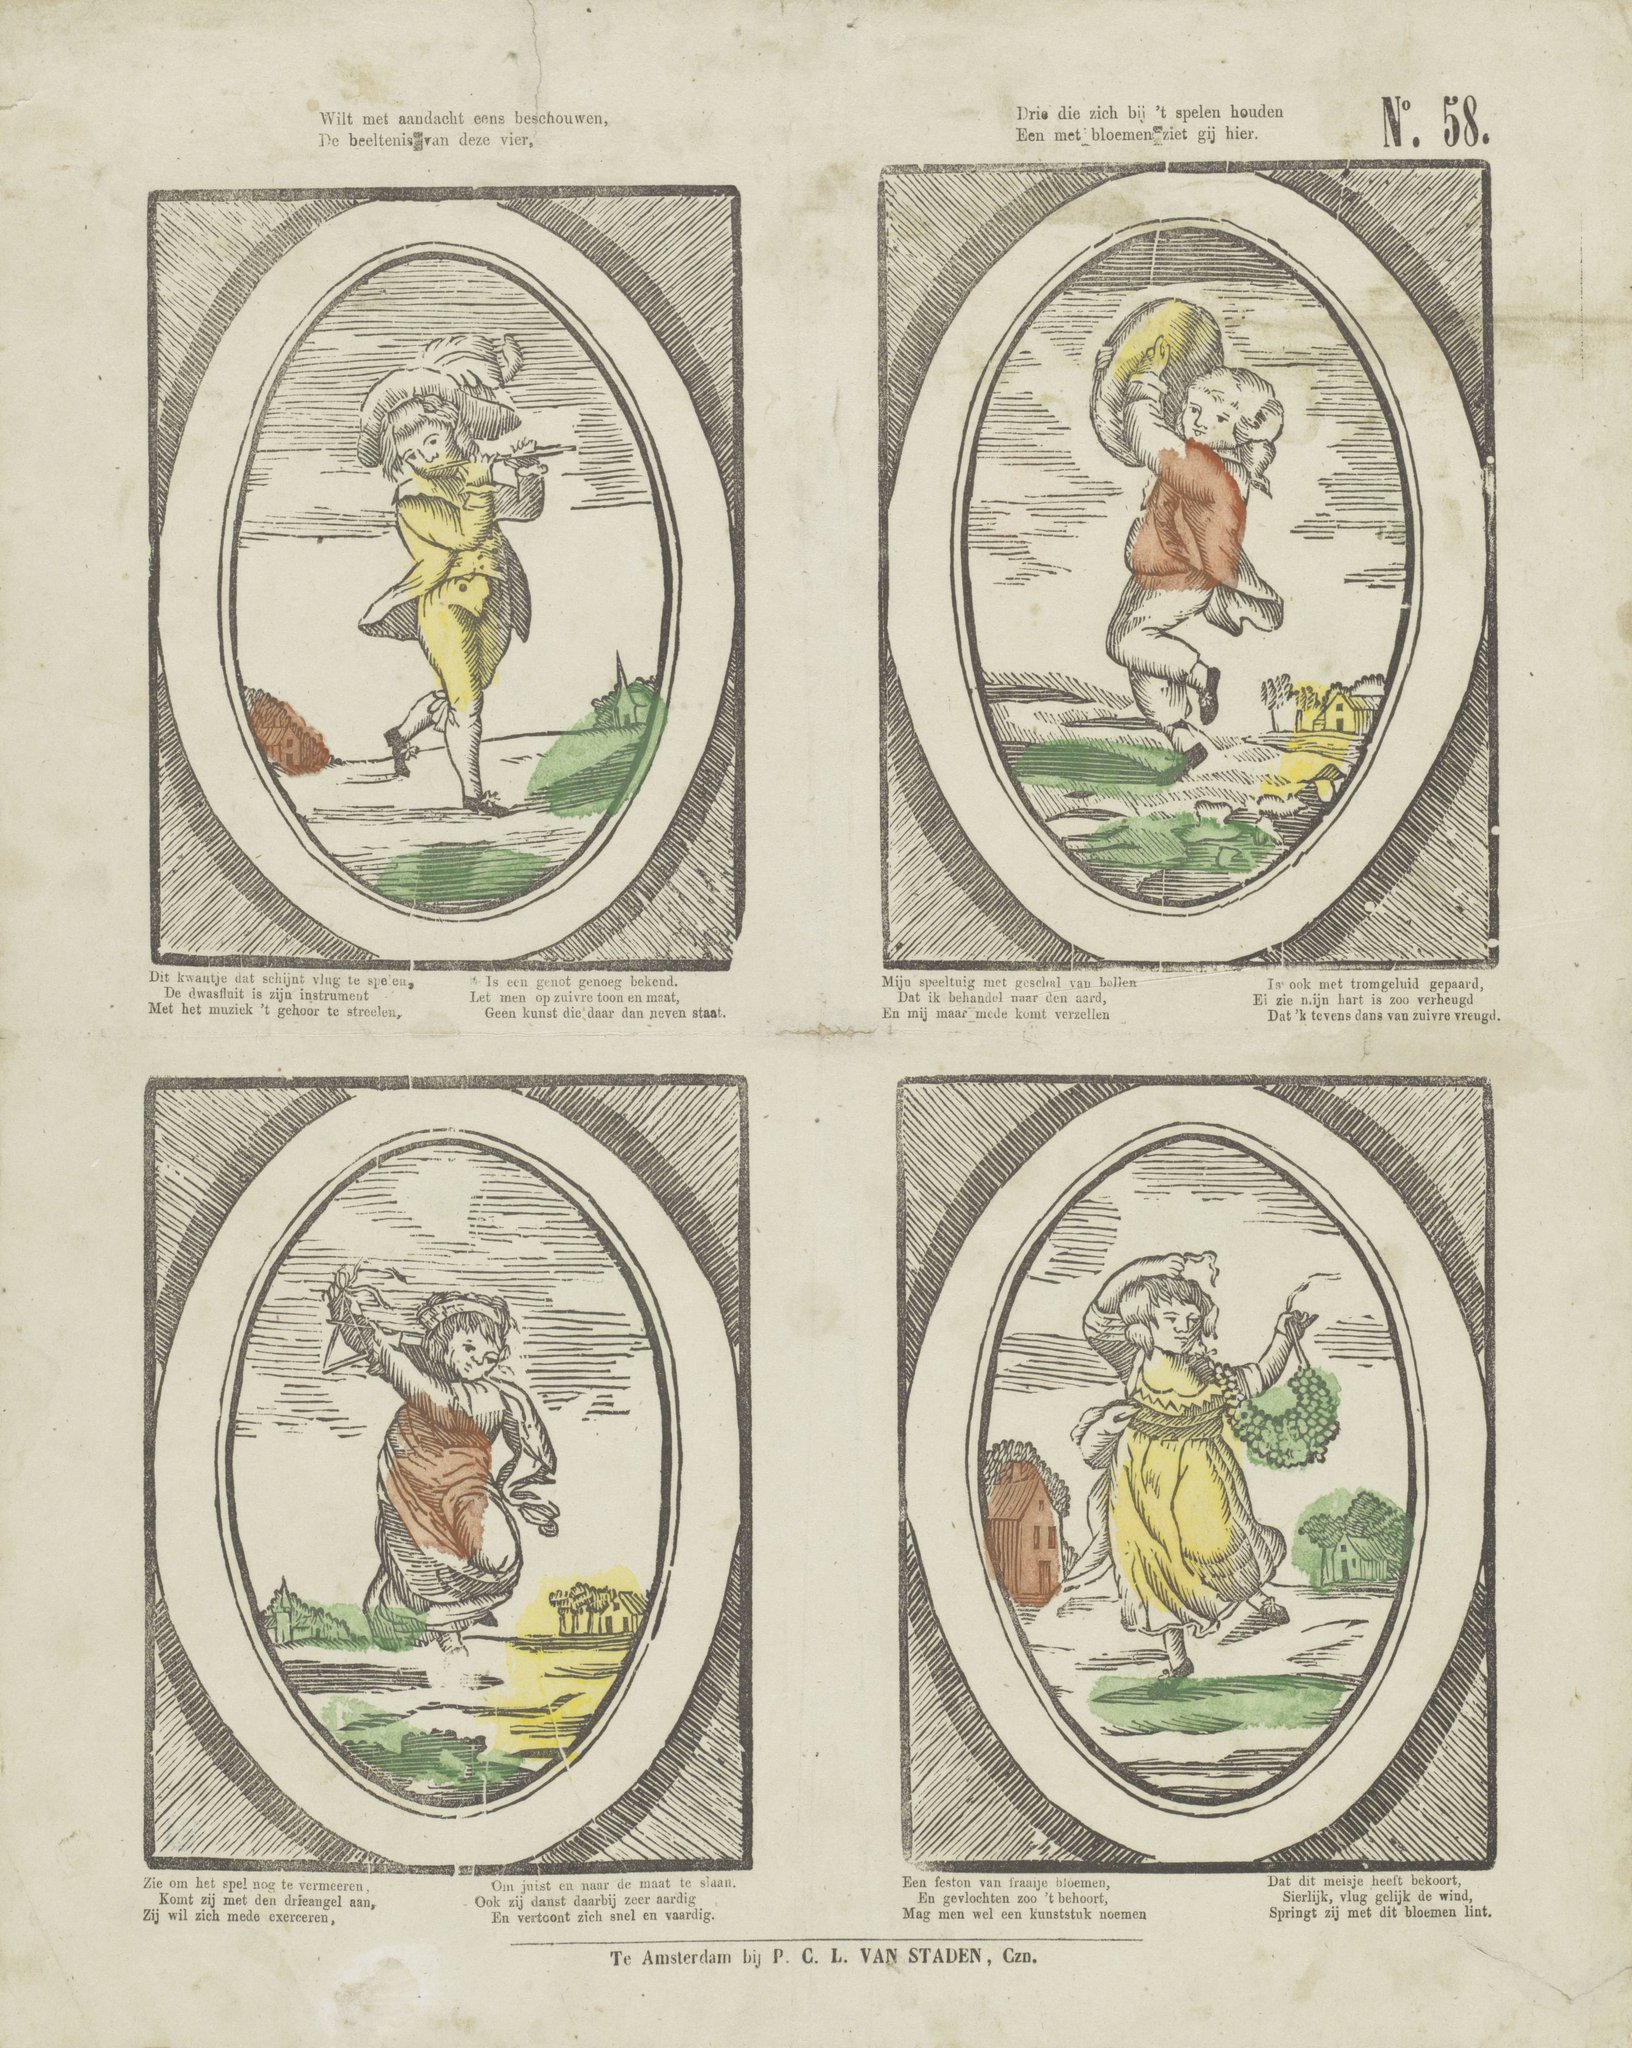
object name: popular print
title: Wilt met aandacht eens beschouwen, / De beeltenis van deze vier, / Drie die zich bij 't spelen houden, / Een met bloemen ziet gij hier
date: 1850-1870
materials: paper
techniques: colour, letterpress printing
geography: amsterdam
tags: making music; musician with instrument, dancing, child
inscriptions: collector's mark: Lugt 2760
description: Blad met 4 voorstellingen van dansende en musicerende kinderen in een ovale lijst. Onder elke afbeelding een zesregelig vers in twee kolommen. Genummerd rechtsboven: No. 58.